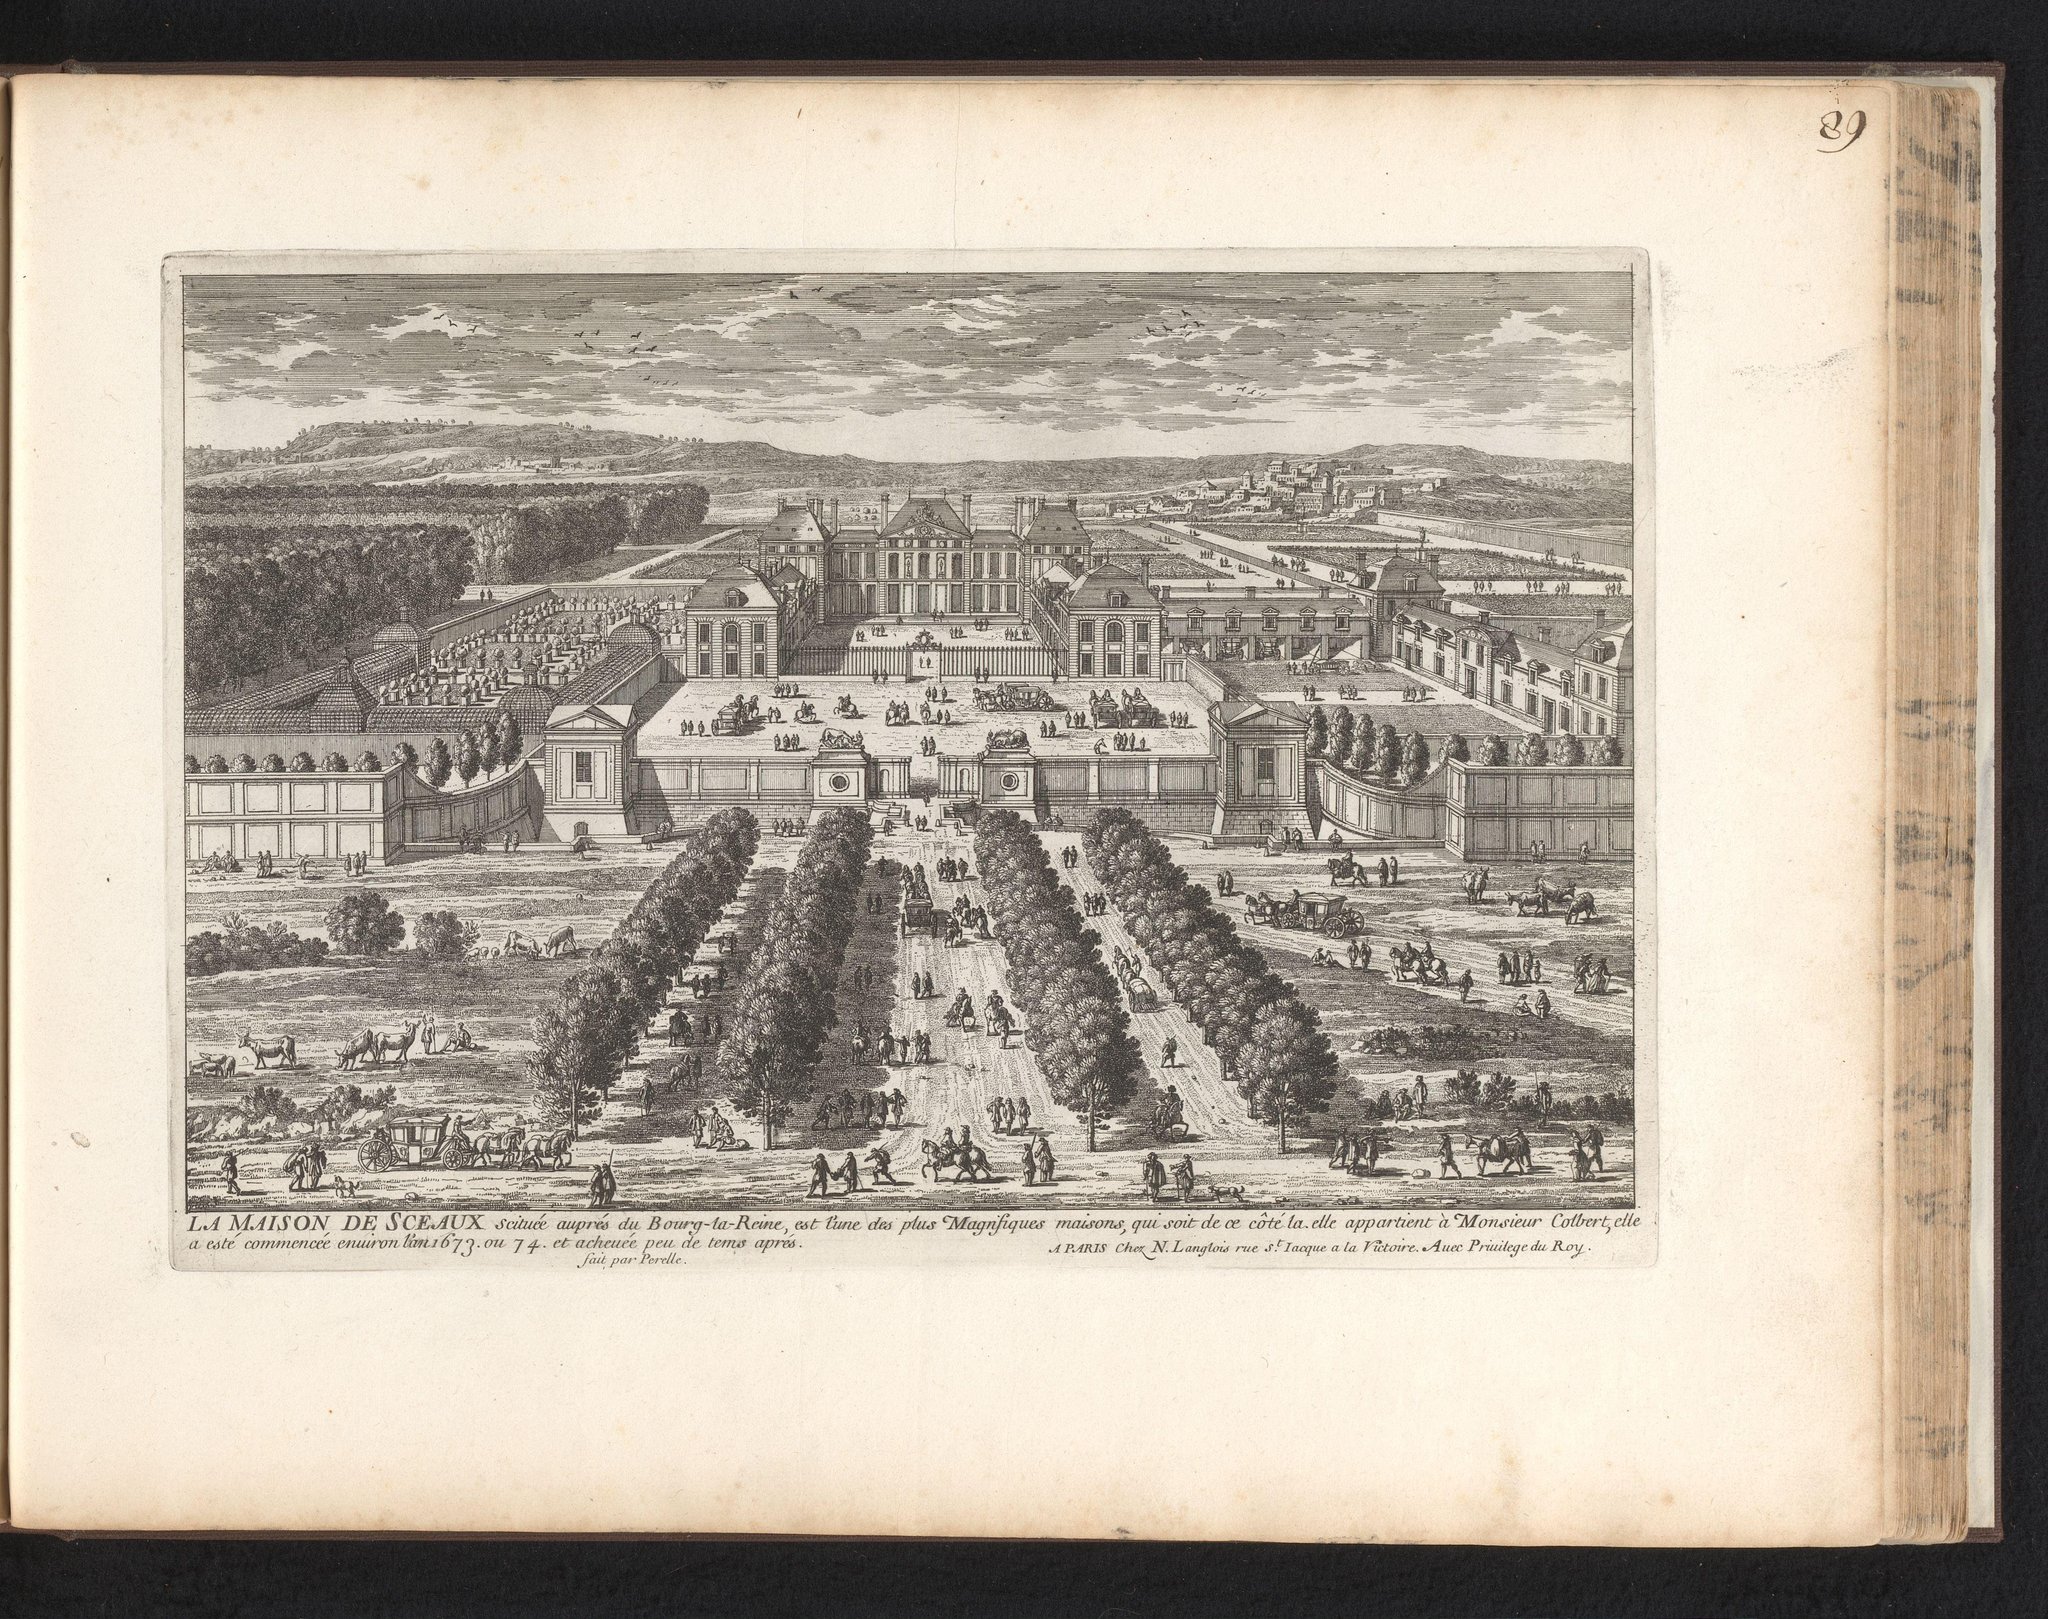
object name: album leaf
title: Stadsgezichten en landschappen in Frankrijk en Italië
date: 1650-1695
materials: paper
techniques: etching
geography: paris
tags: landscape with tower or castle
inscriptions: collector's mark: Lugt 2228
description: Prenten met het signatuur 'Perelle' kunnen zowel door vader Gabriel als door zonen Nicolas en Adam gemaakt zijn. De uitgevers vader en zoon Nicolas Langlois worden allebei vermeld als N. Langlois op hetzelfde adres.